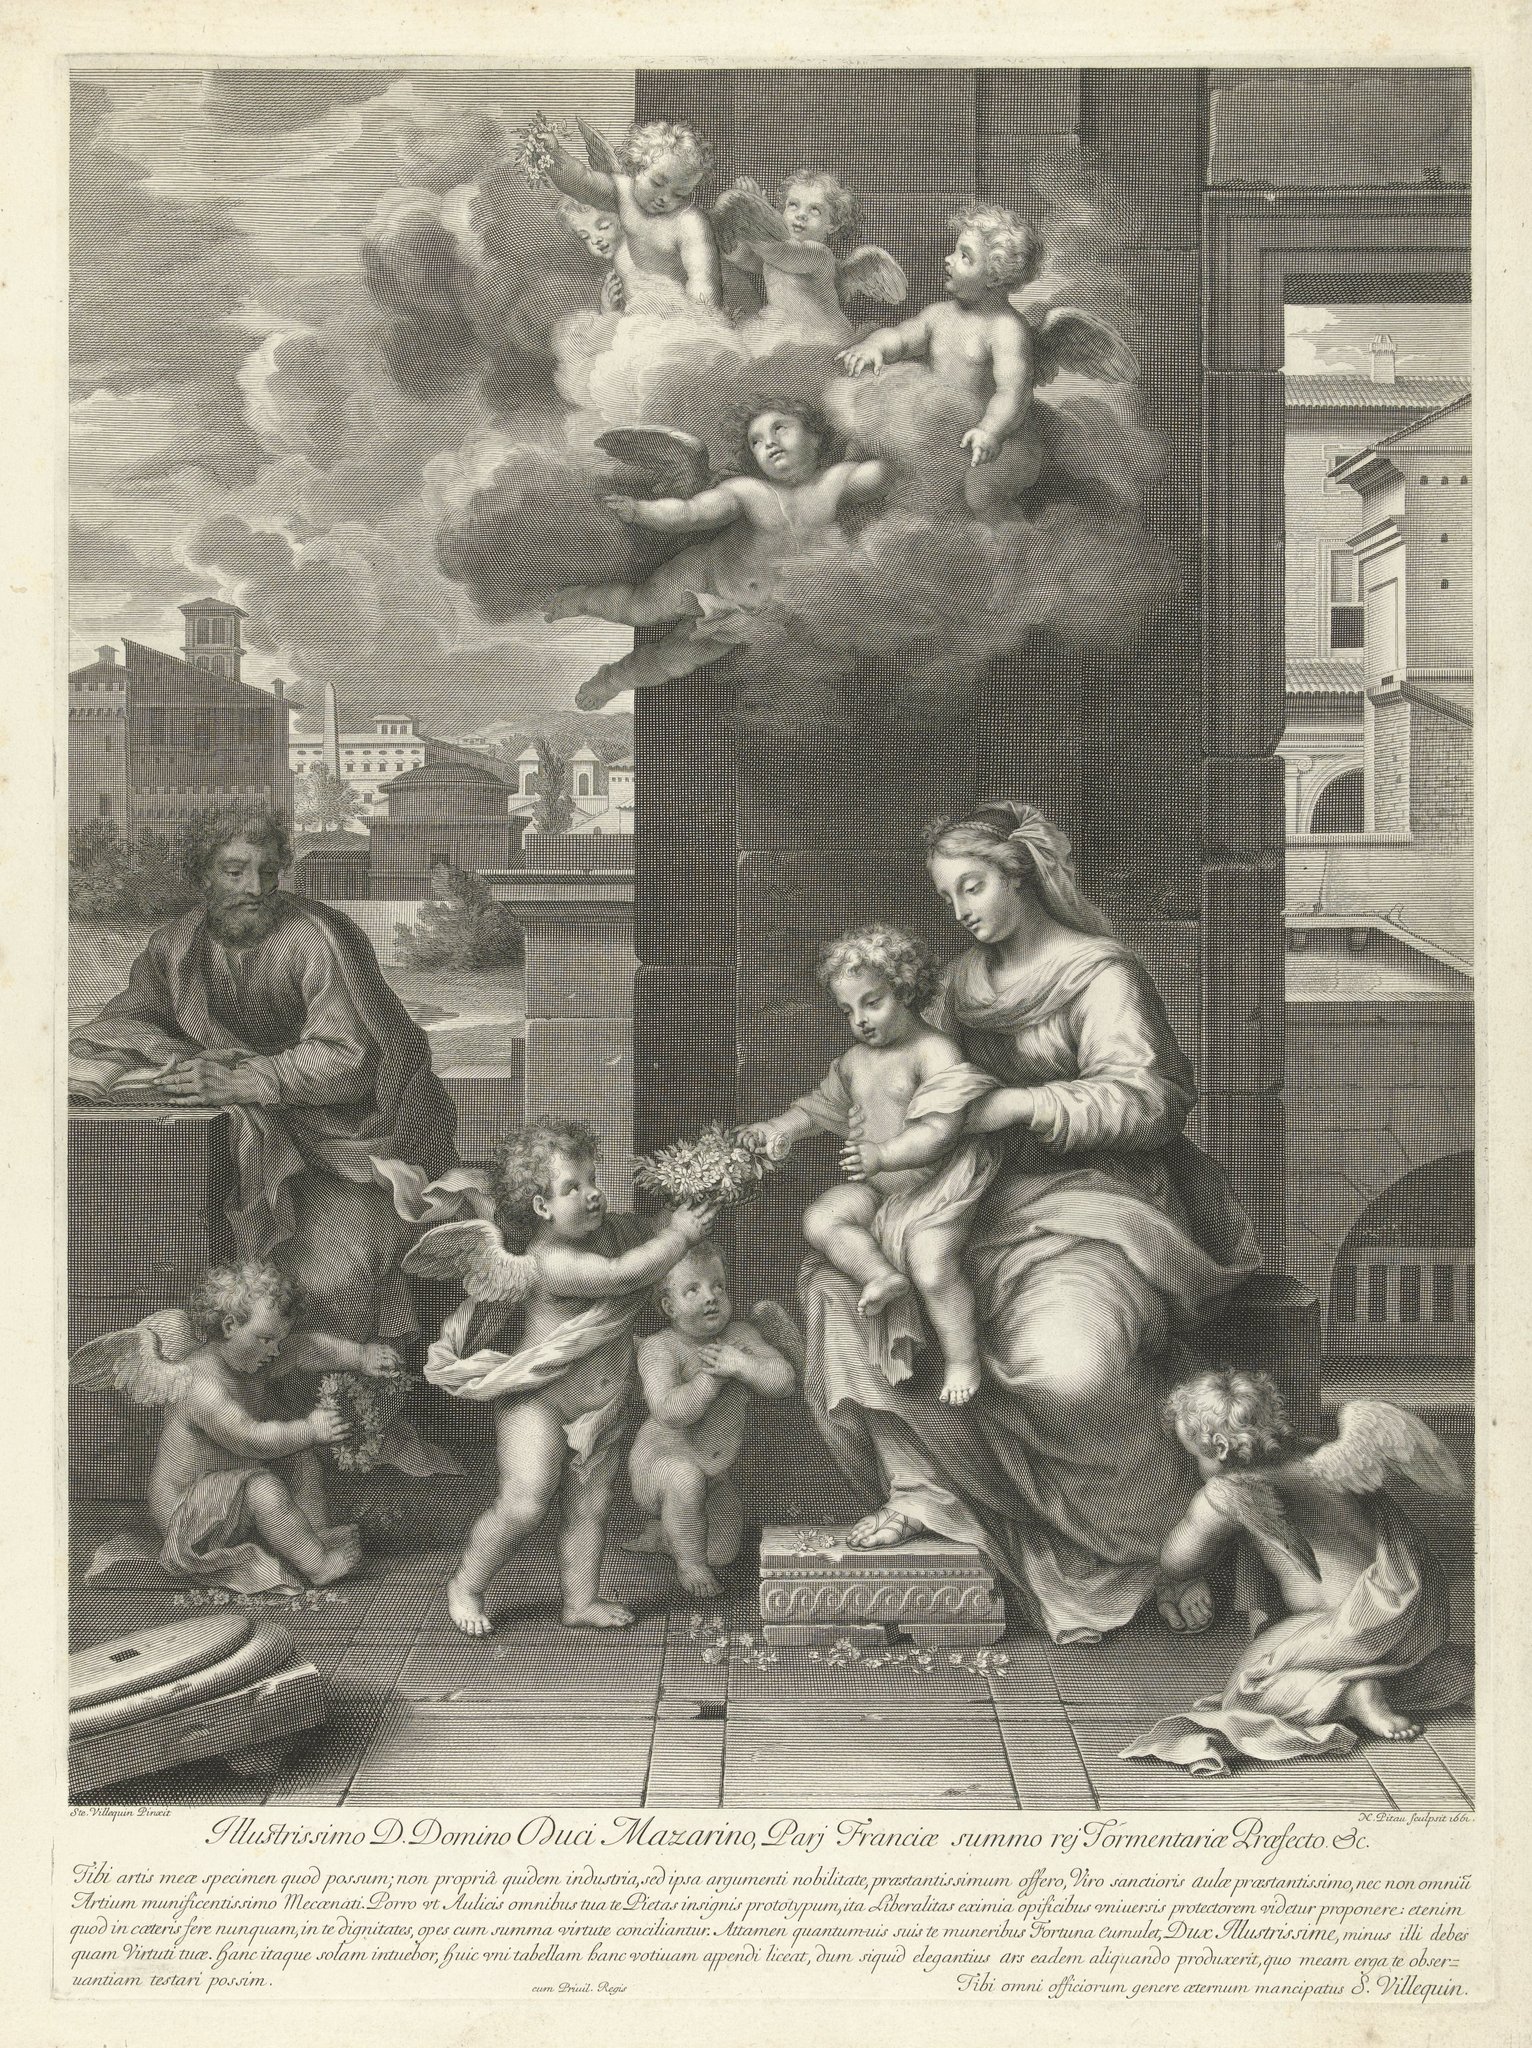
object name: print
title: Heilige Familie en engelen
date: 1661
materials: paper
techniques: engraving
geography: paris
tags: holy family, and derived representations (+ angel(s))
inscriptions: inscription: ‘V4 b: h:’, collector's mark: Lugt 240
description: Maria zit met het Christuskind op schoot. Engelen bieden hem een mand met bloemen aan. Jozef kijkt toe. Op een wolk boven hen engelen met bloemenkransen. Op de achtergrond een gezicht op een stad. In de marge een zesregelig onderschrift met een opdracht in het Latijn.